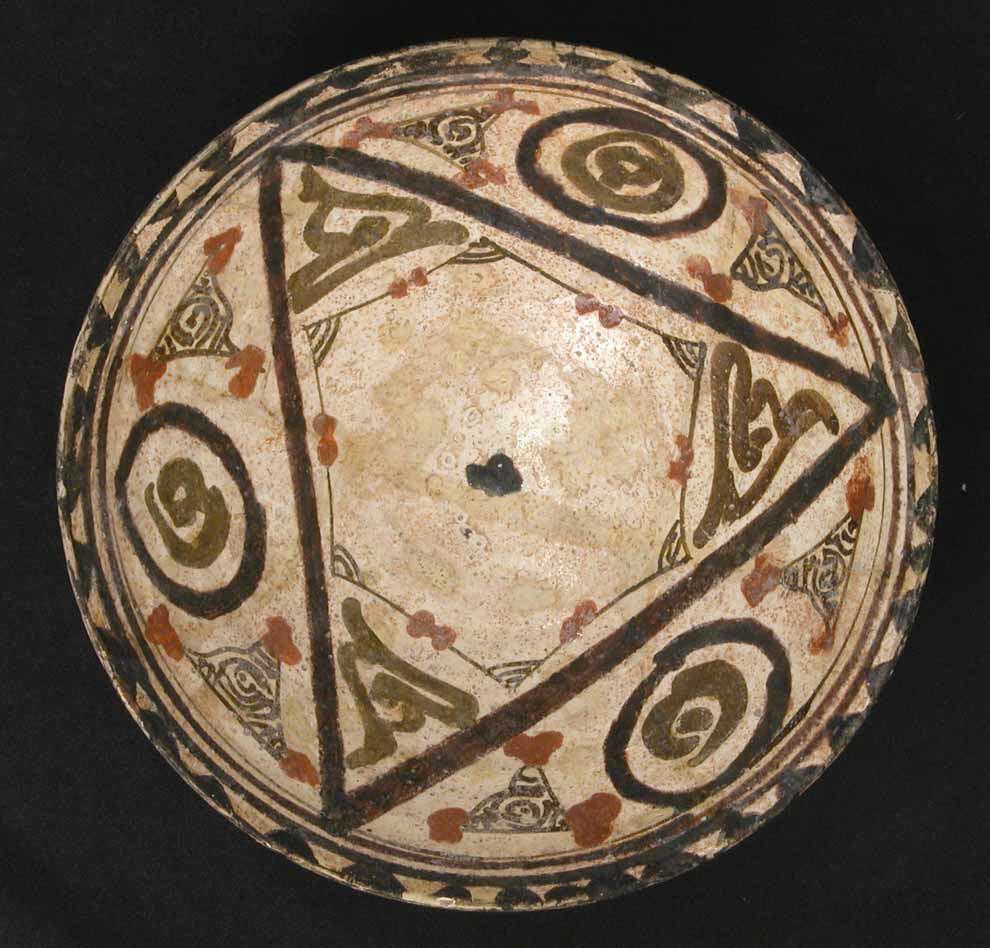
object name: bowl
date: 901-1000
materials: earthenware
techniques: painting, underglaze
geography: iran